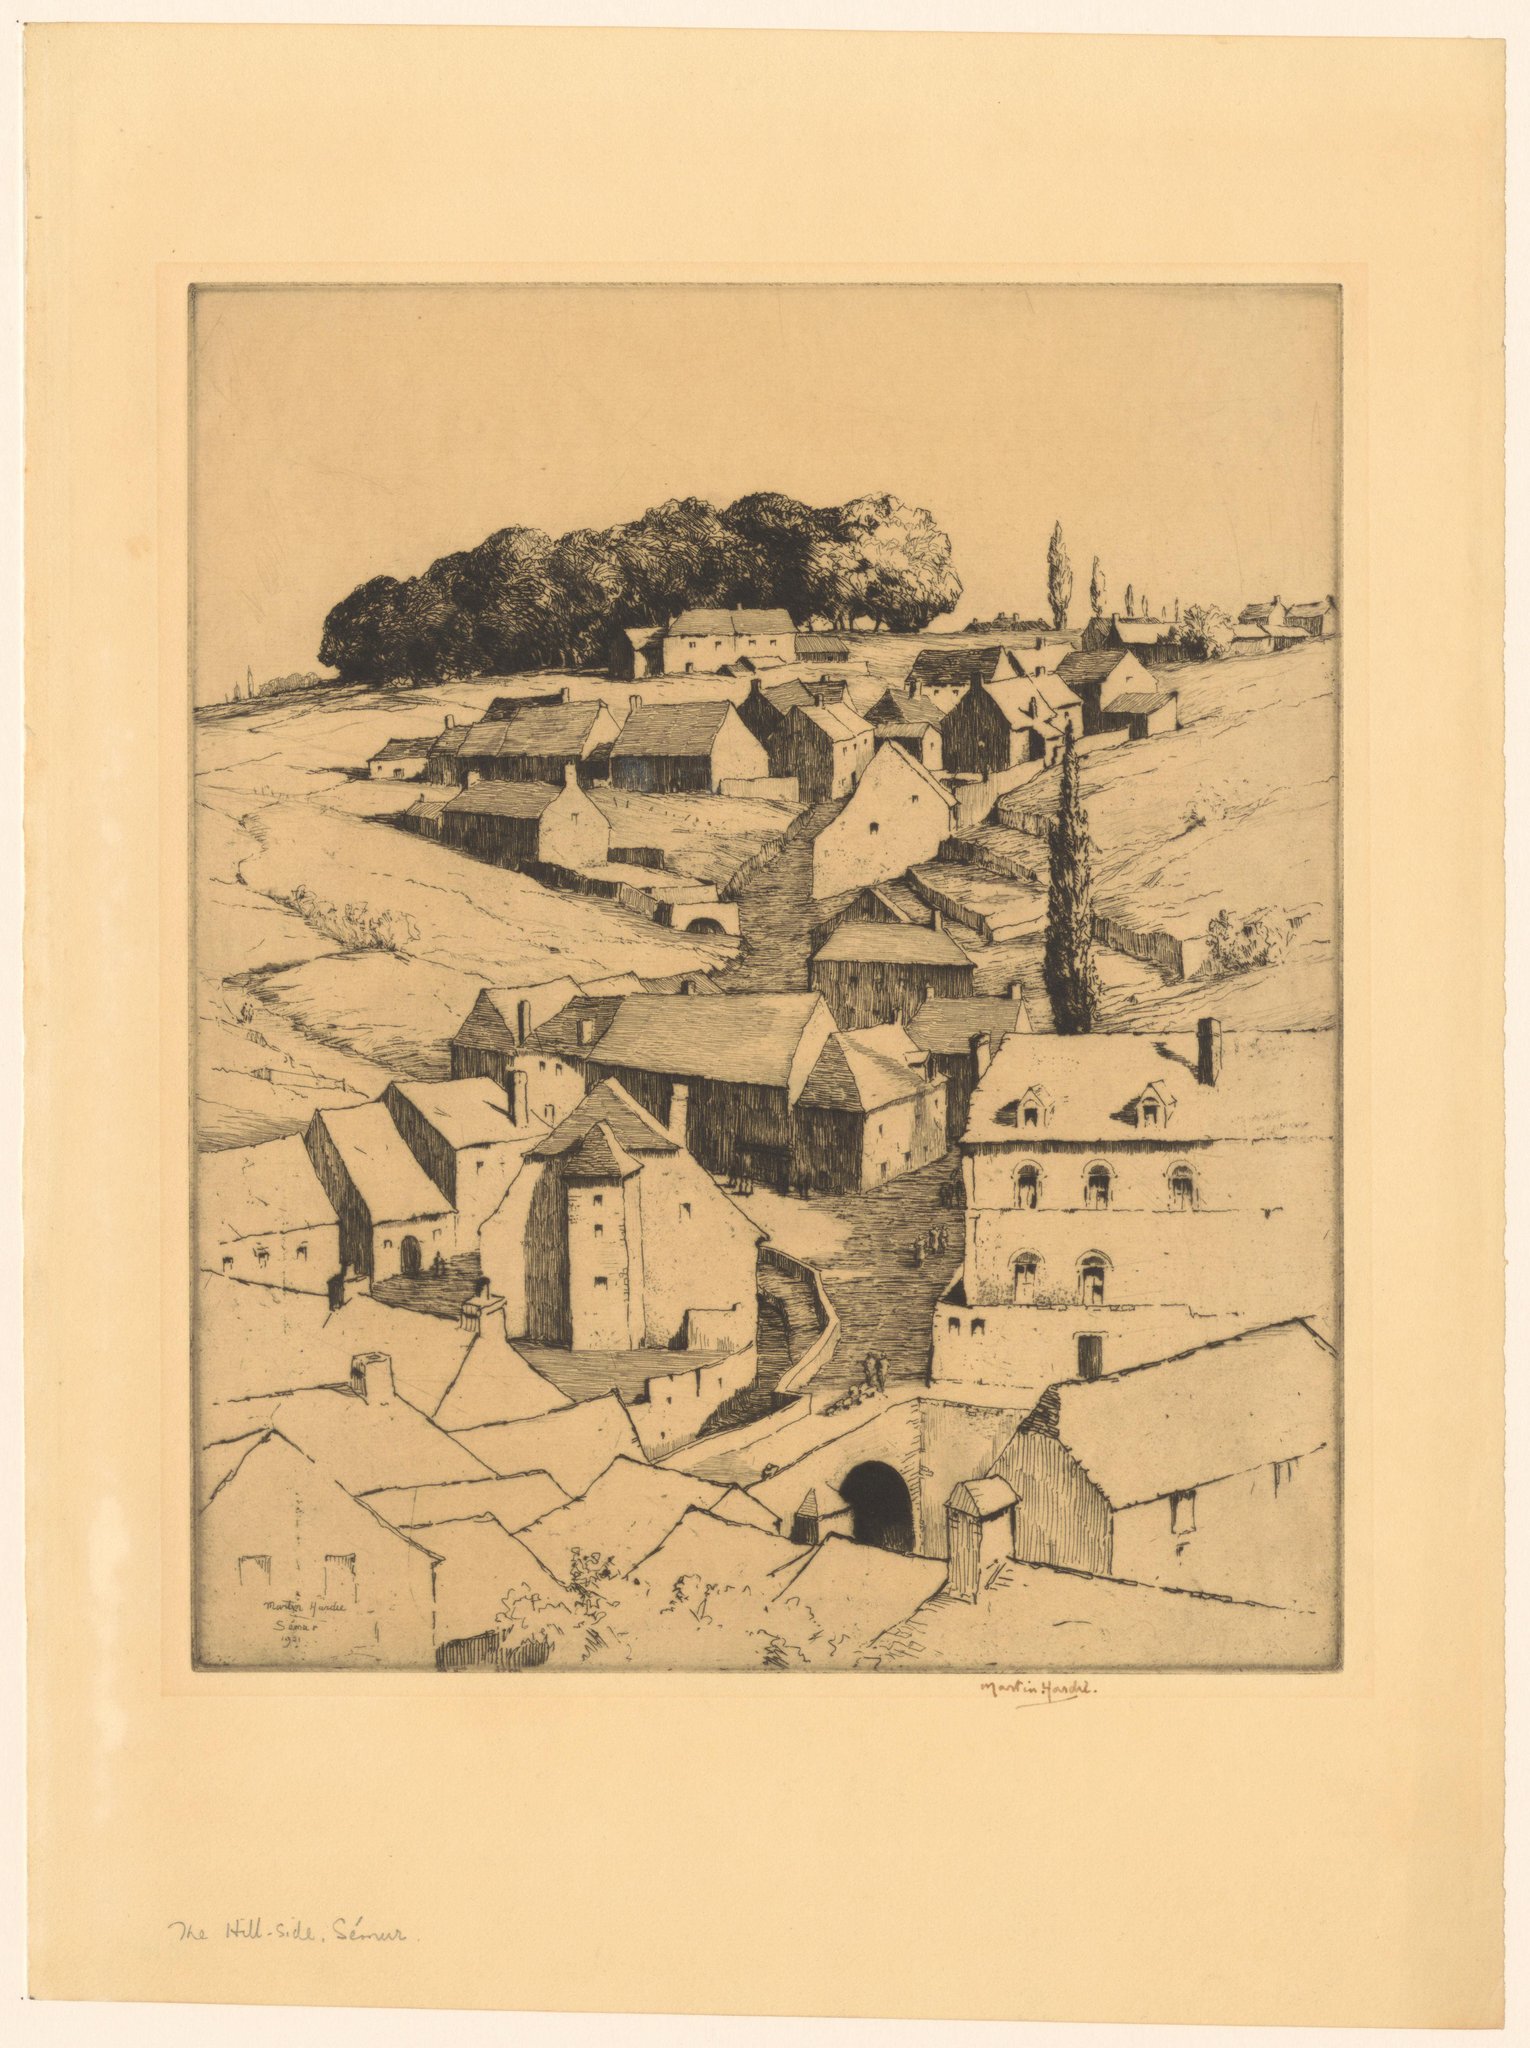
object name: print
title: The Hill-Side Semur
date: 1921-1929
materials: paper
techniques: etching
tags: sloping street; street with steps or stairs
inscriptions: annotation: ‘Martin Hardie’, collector's mark: Lugt 2228